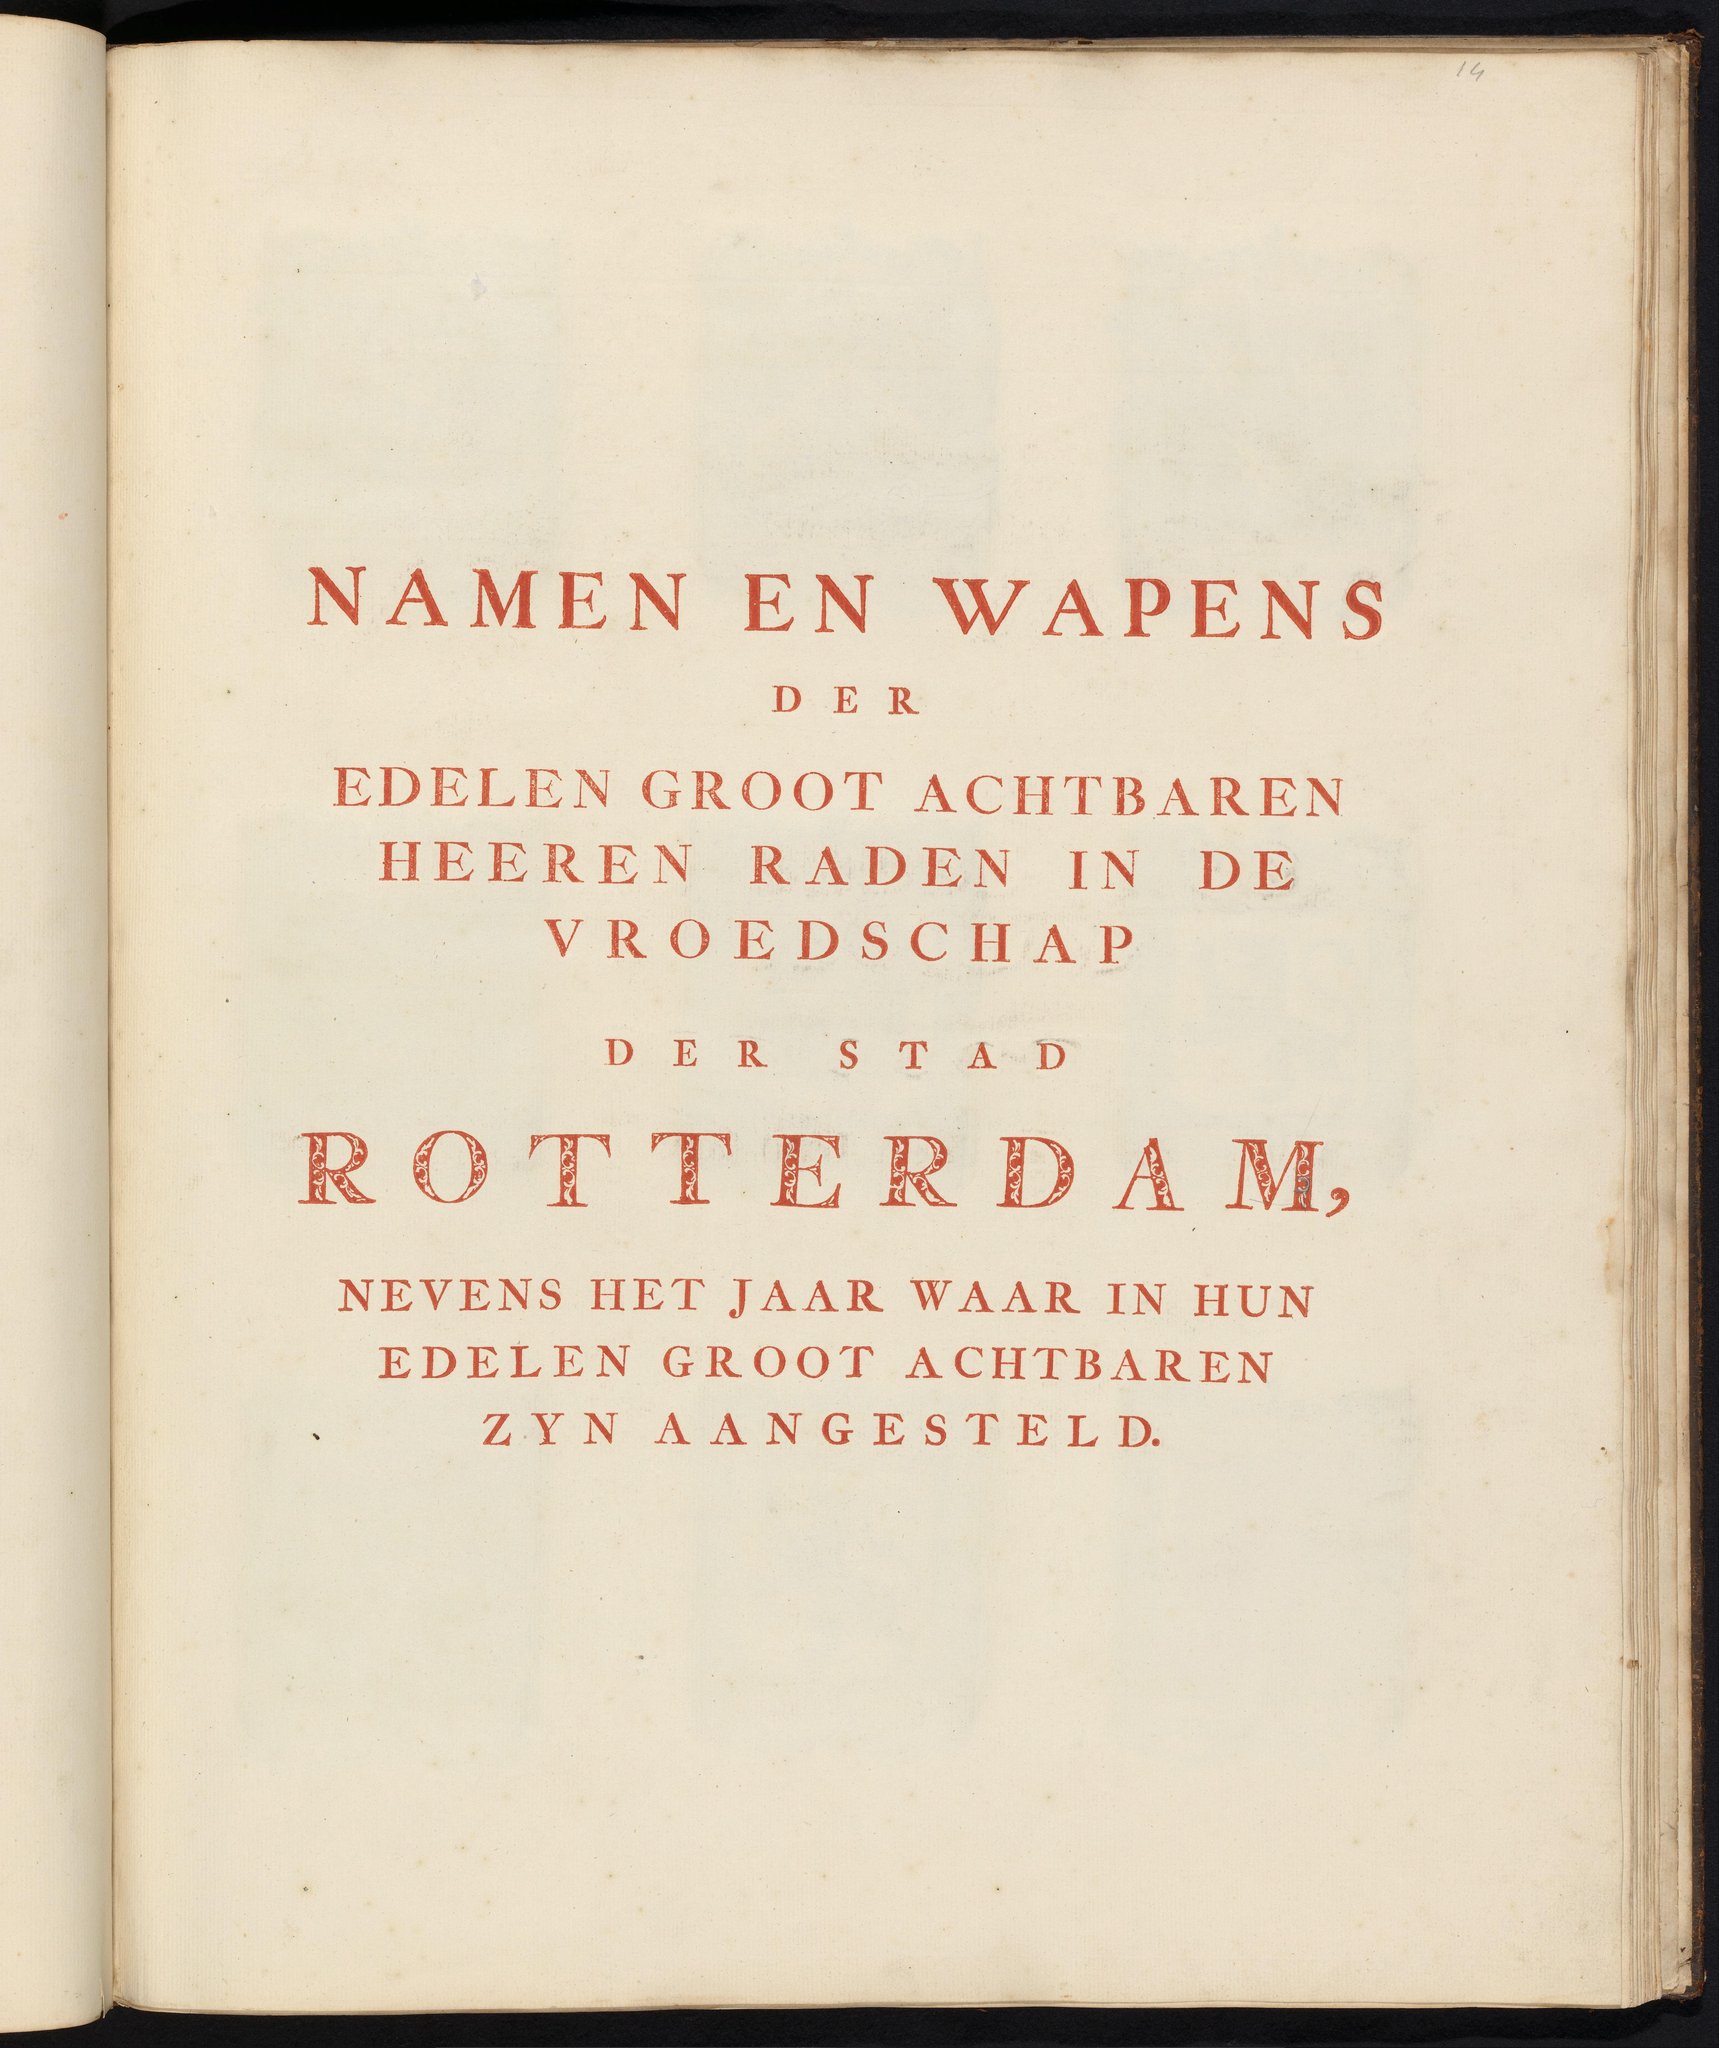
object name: album leaf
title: Tussentitel voor het album met de kaart van Rotterdam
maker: Anonymous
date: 1783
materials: paper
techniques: letterpress printing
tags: title-page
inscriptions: collector's mark: ‘Ministerie van Oorlog / Archief / Afdeling Genie’